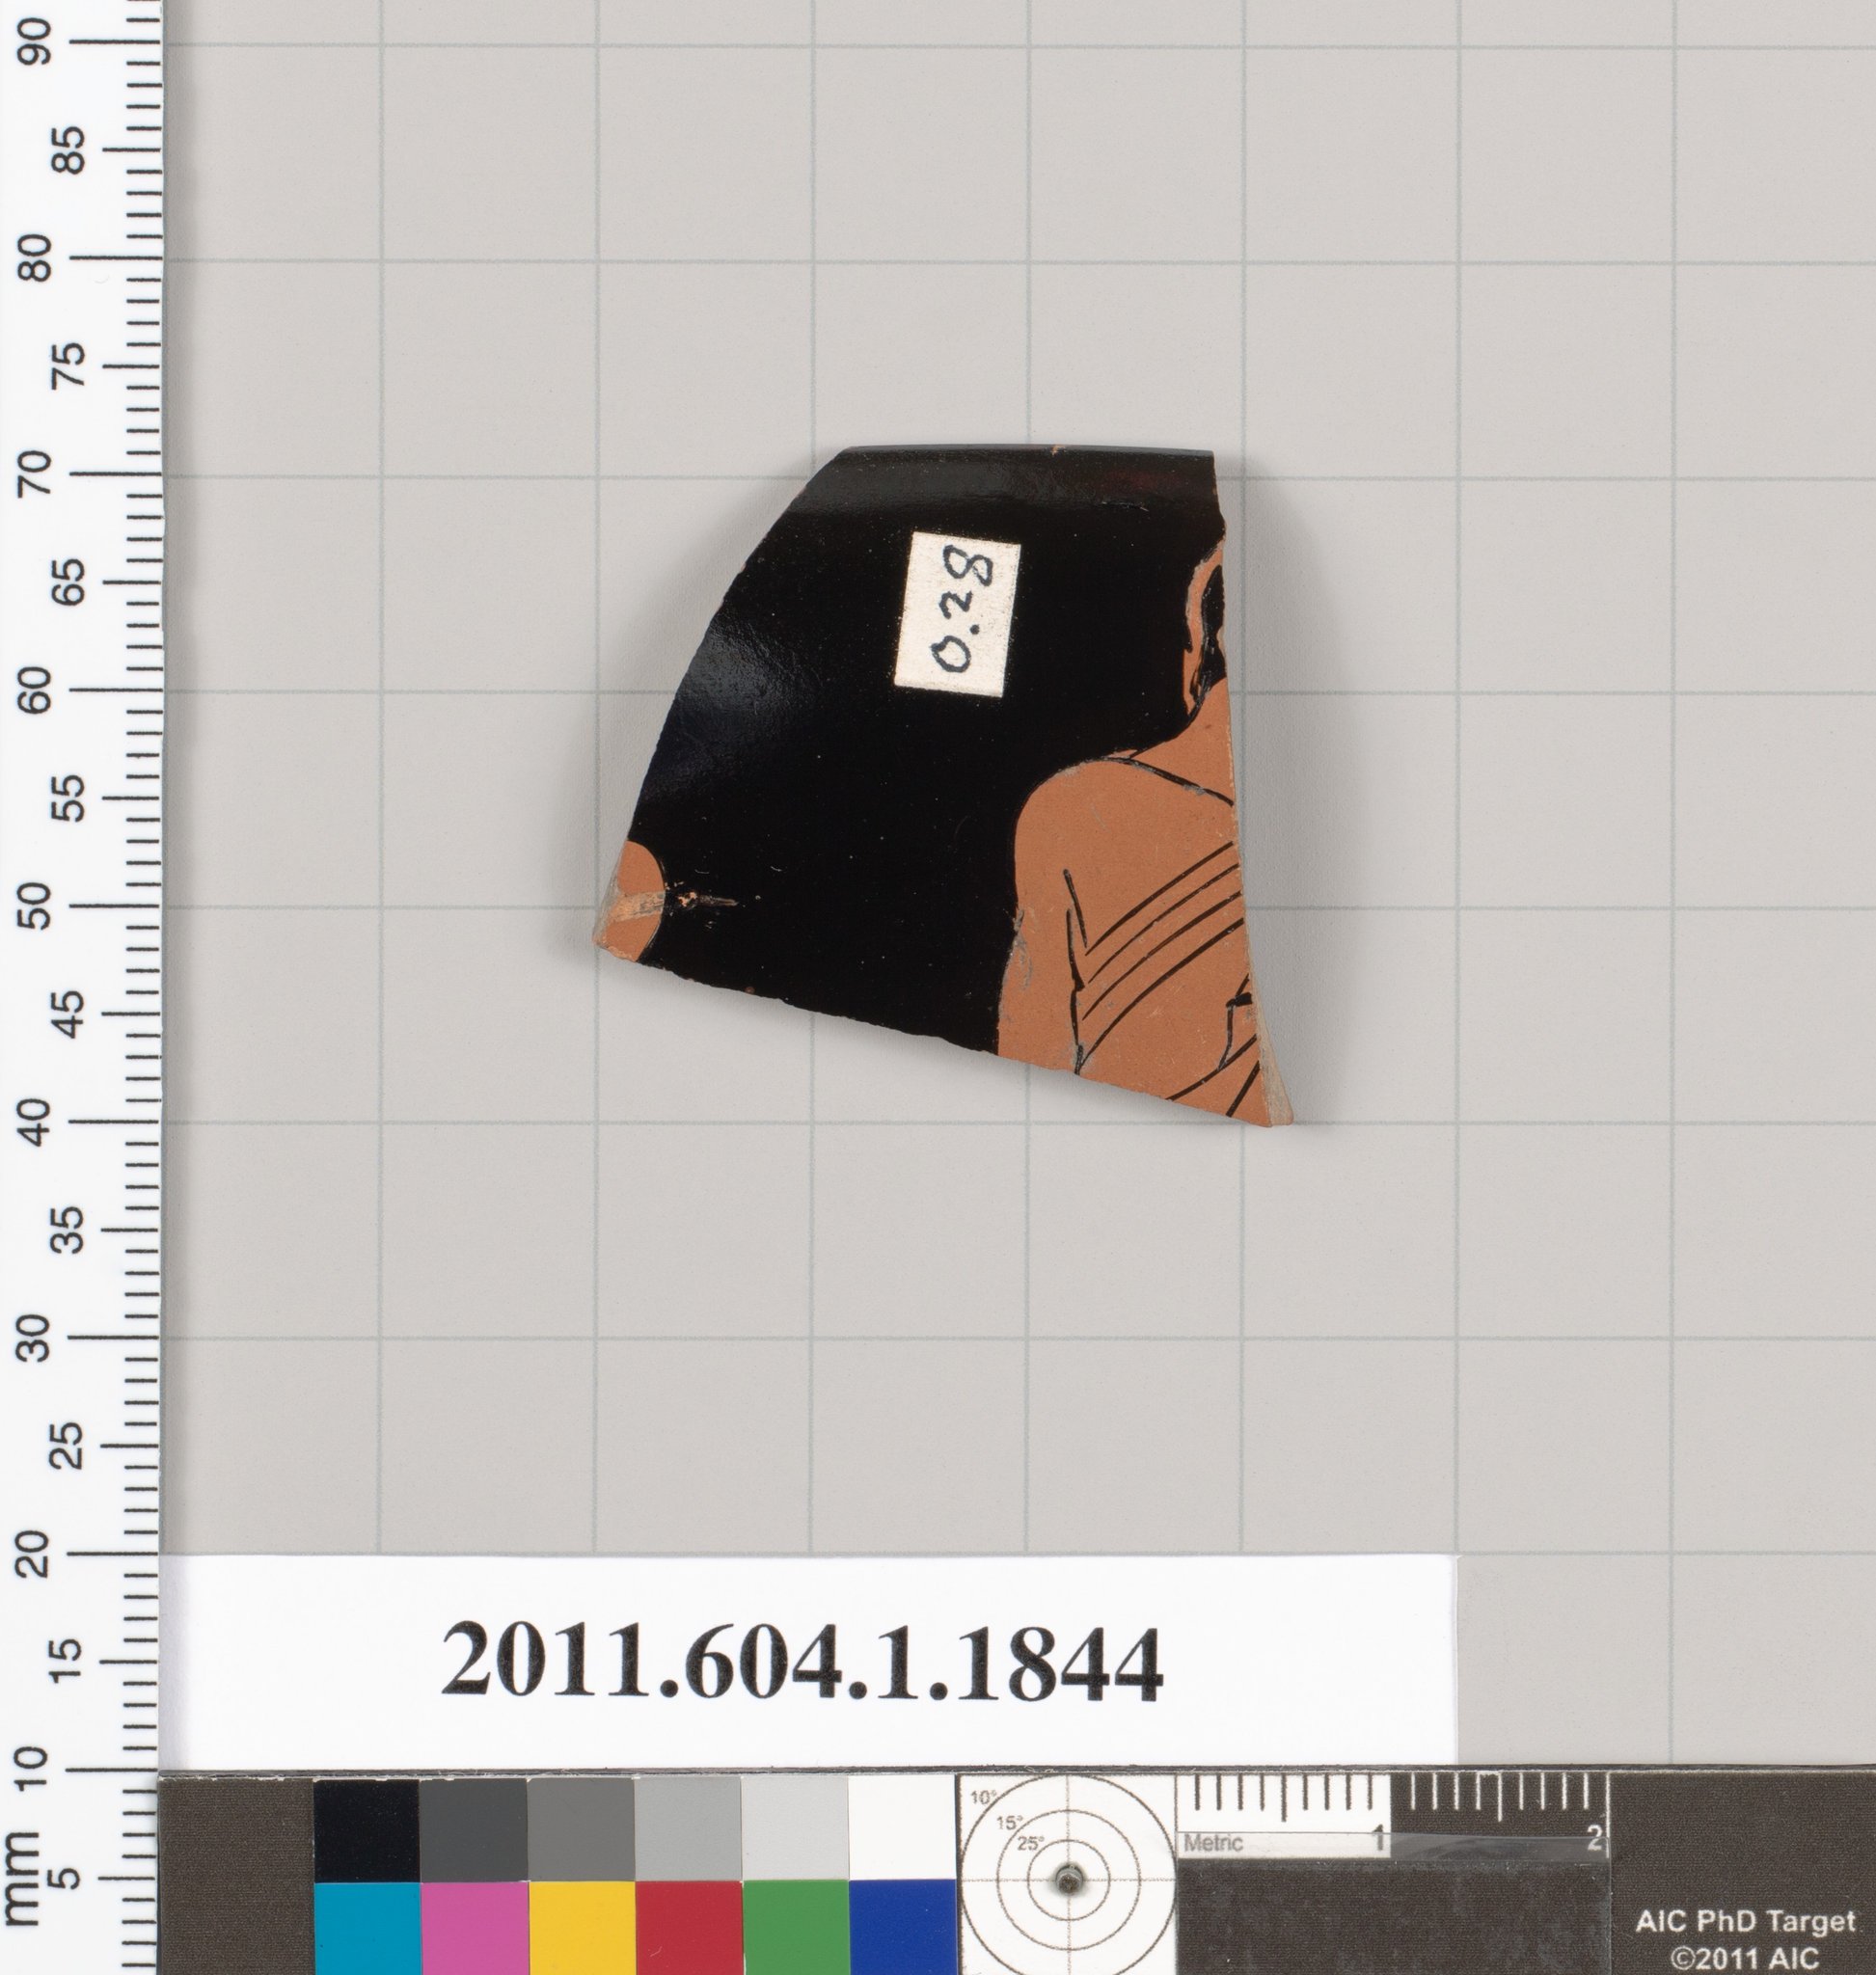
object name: kylix fragment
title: Terracotta rim fragment of a kylix (drinking cup)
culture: greek, attic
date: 470-460 BCE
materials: terracotta